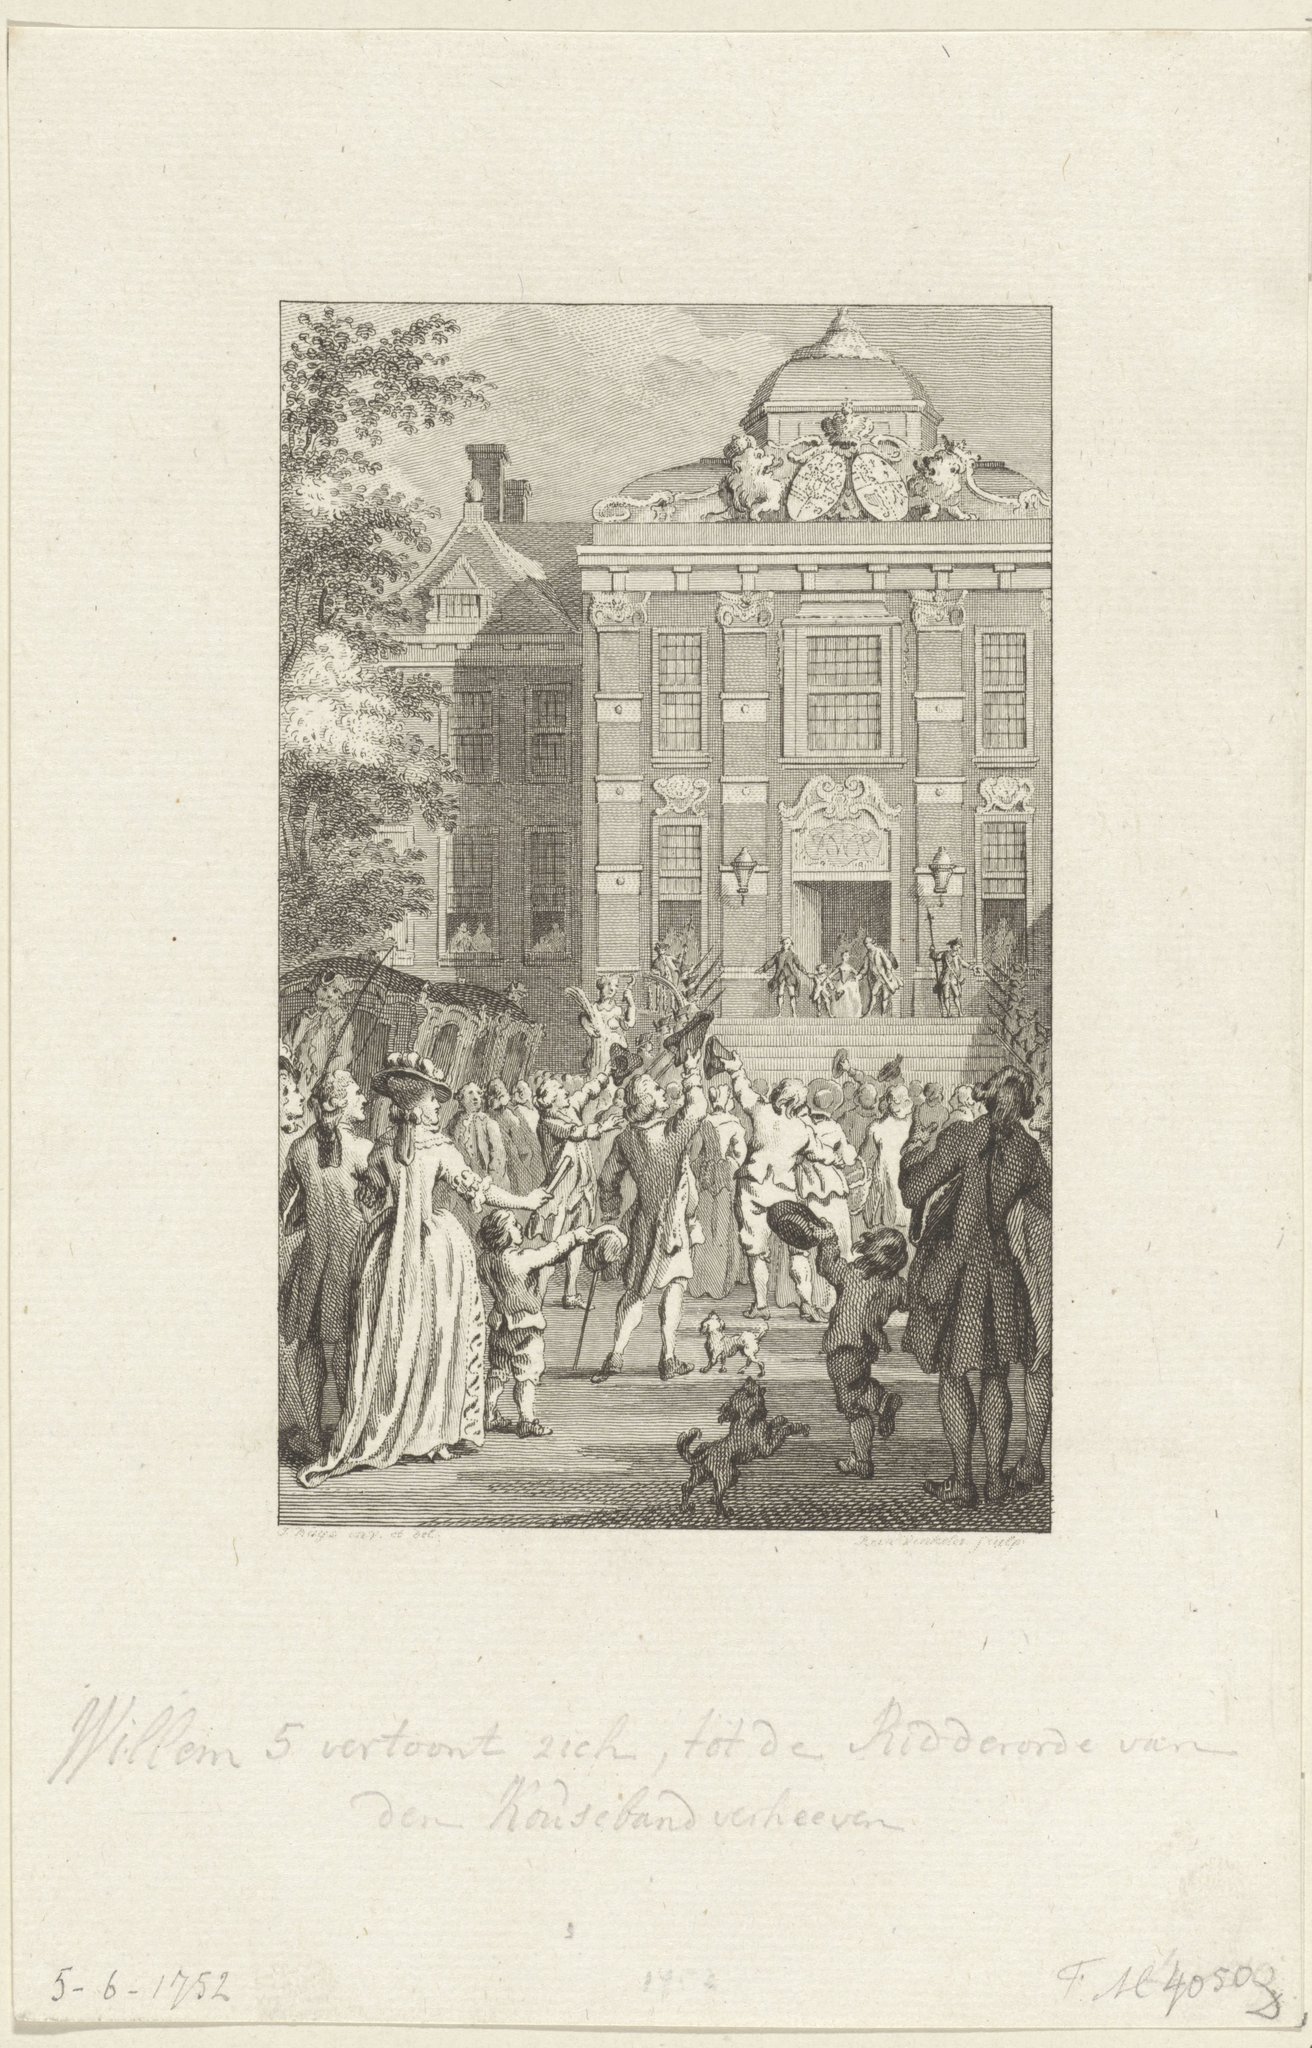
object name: history print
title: Willem V vertoont zich als Ridder in de Orde van de Kousenband op het bordes van Huis ten Bosch, 1752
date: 1788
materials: paper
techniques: engraving, etching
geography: amsterdam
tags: the hague, william v (prince of orange), knighthood order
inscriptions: collector's mark: Lugt 240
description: Gebruikt als illustratie in: P.A. Loosjes, Vaderlandsche historie, vervattende de geschiedenissen der Vereenigde Nederlanden (...).Twee-en-twintigste deel. Beginnende met den jaare 1752 en eindigende met den jaare 1758 ... ten onmiddelyken vervolge van Wagenaar's Vaderlandsche historie.